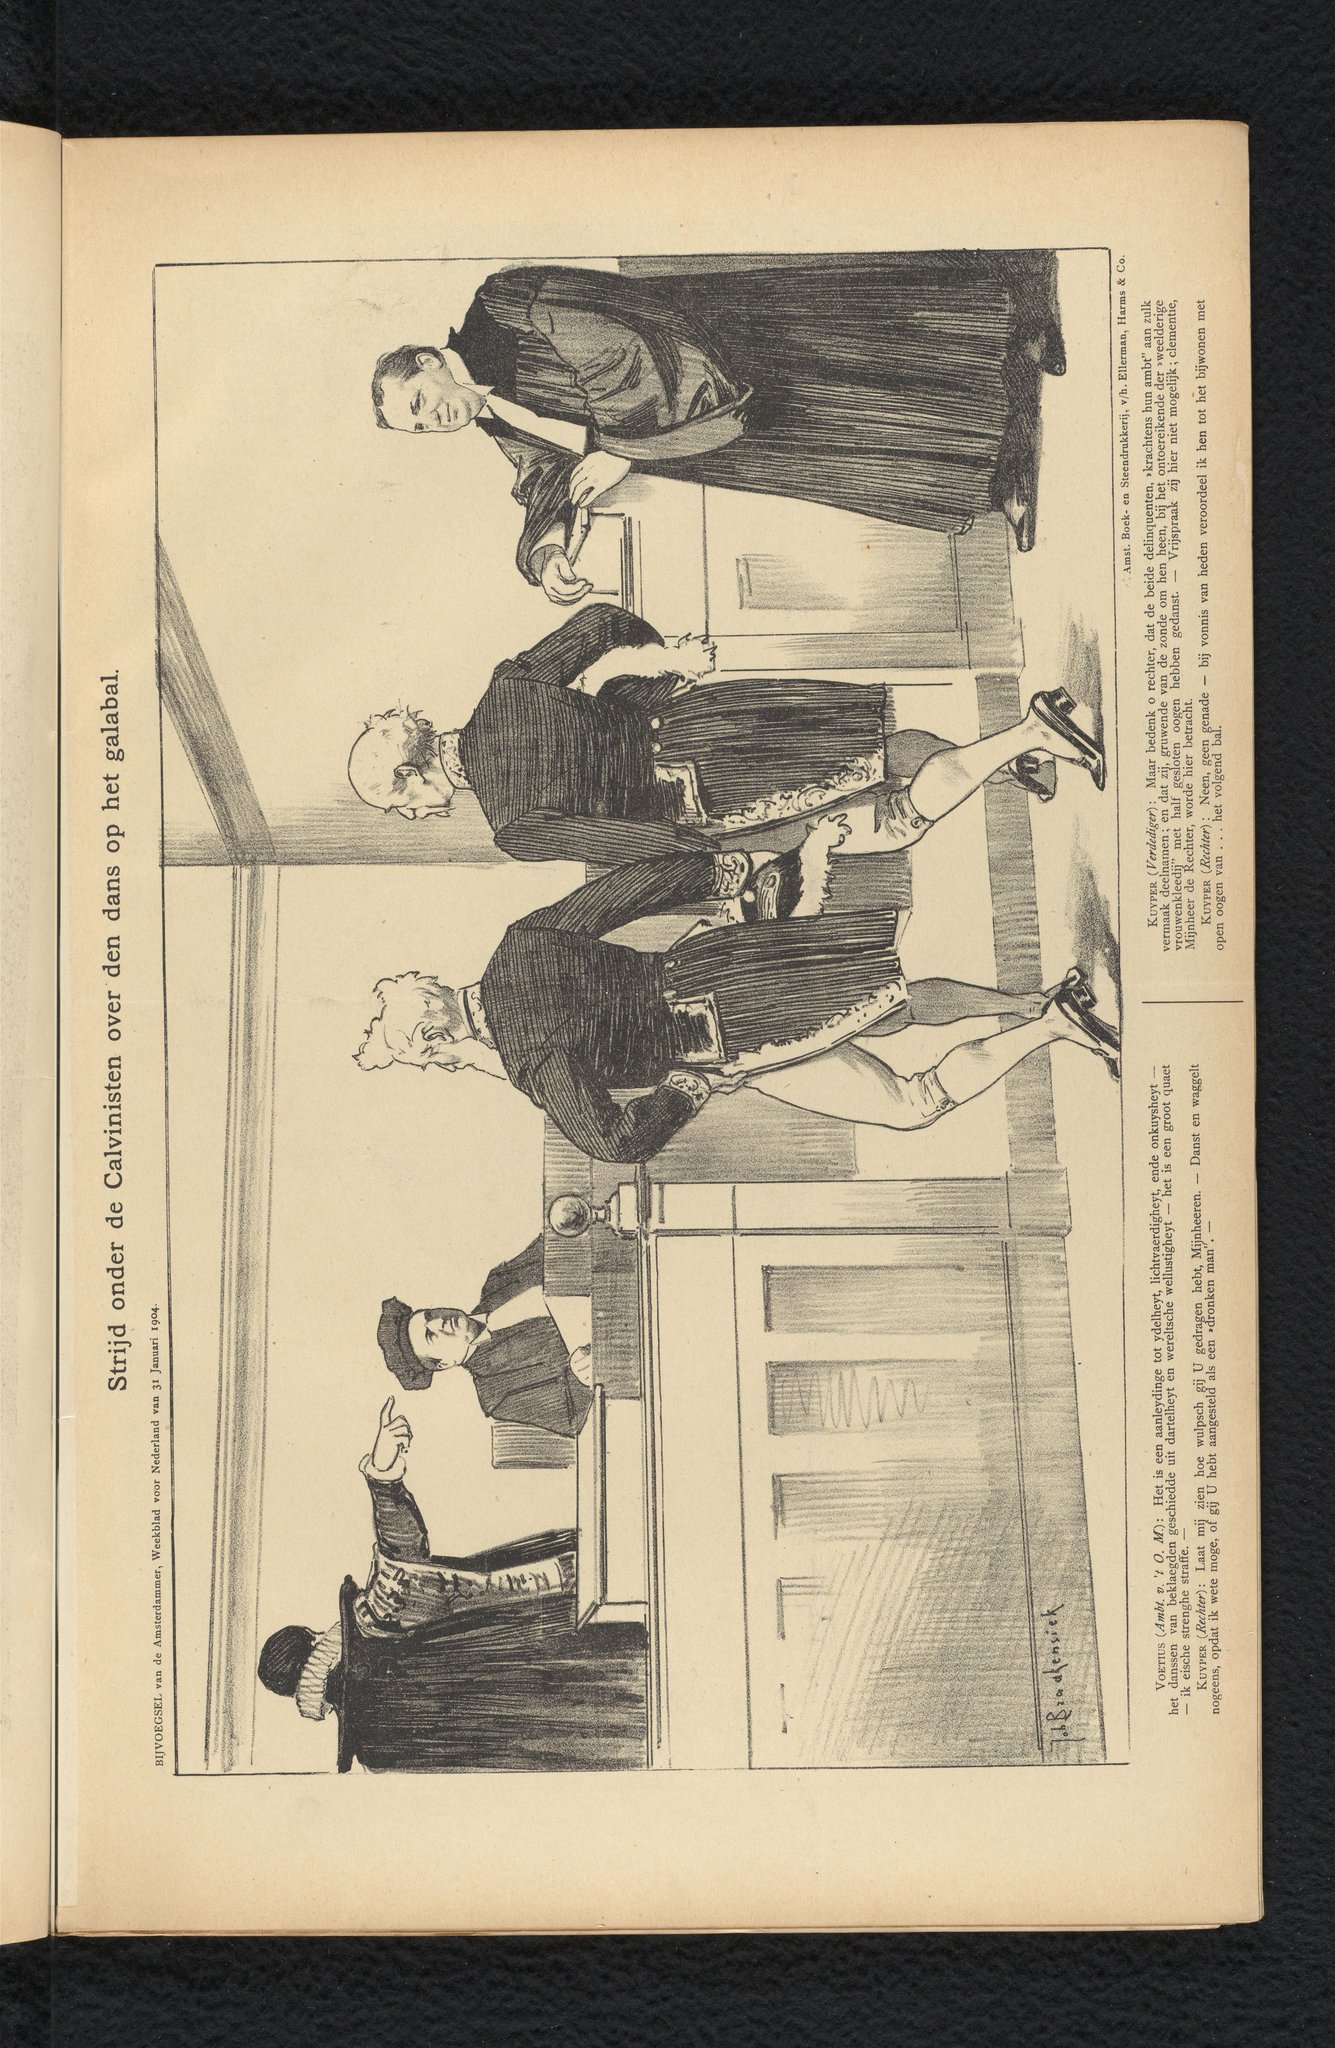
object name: cartoon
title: Strijd onder de Calvinisten over den dans op het galabal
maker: johan braakensiek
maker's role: draughtsman, print maker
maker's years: 1858-1940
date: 1904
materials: paper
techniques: lithograph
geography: amsterdam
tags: delft, the hague, abraham kuyper, utrecht, ball, formal dance, court session (court of justice), political caricatures and satires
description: Premier Abraham Kuyper als rechter en advocaat in een strafzaak tegen twee ministers (Melvil van Lynden en Bergansius?) die, vanuit het calvinistische perspectief van de aanklager Voetius, te lichtvaardig en onkuis hebben gedanst op het galabal. De ministers moeten aan de rechter voordoen hoe zij gedanst hebben.